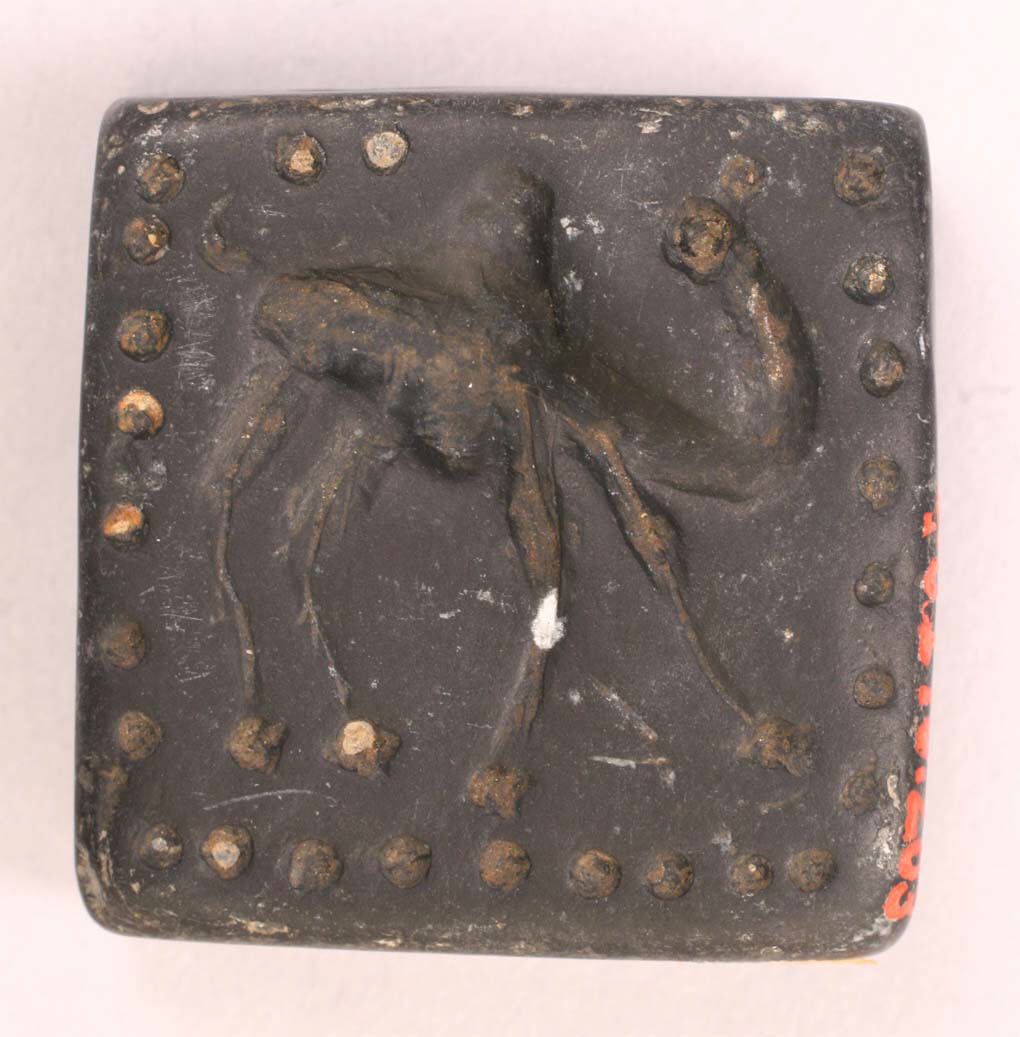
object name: seal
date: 801-1200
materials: stone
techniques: carving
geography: iran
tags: animals